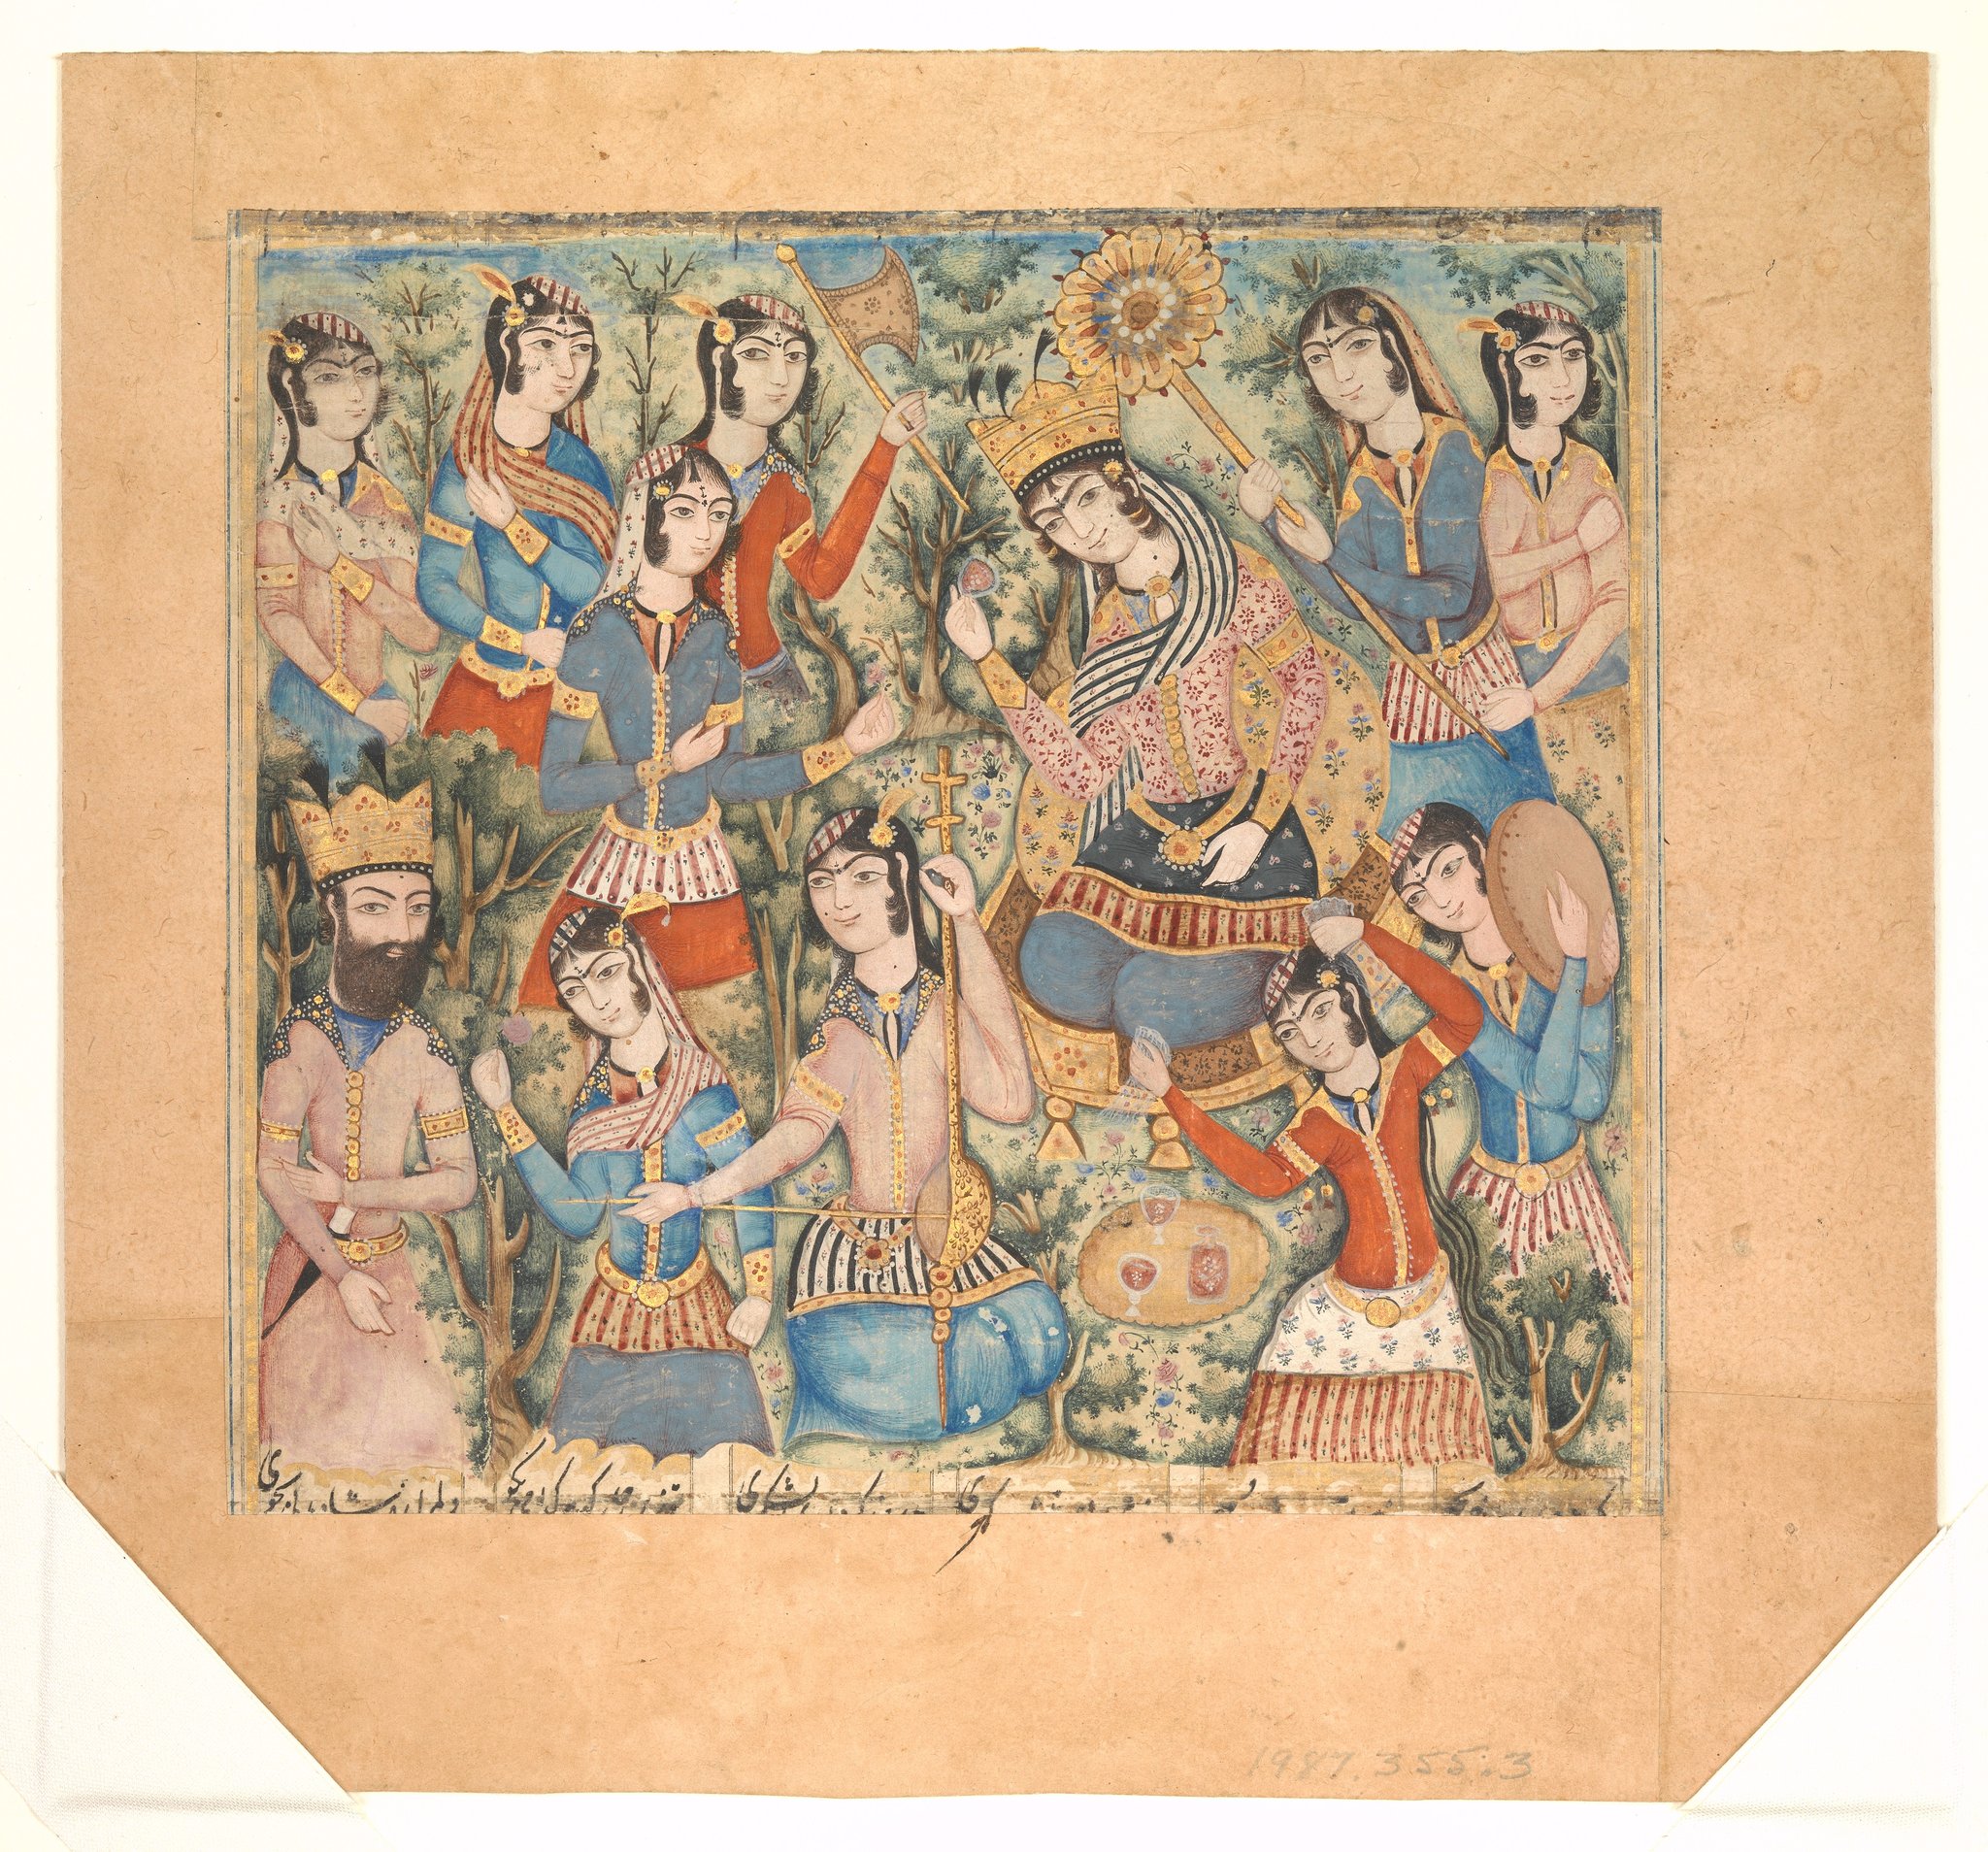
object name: folio from an illustrated manuscript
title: Enthroned Queen and Prince Surrounded by Musicians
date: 1801-1833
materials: gold, ink, paper, watercolor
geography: iran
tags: musical instruments,kings,queens,women,dancers